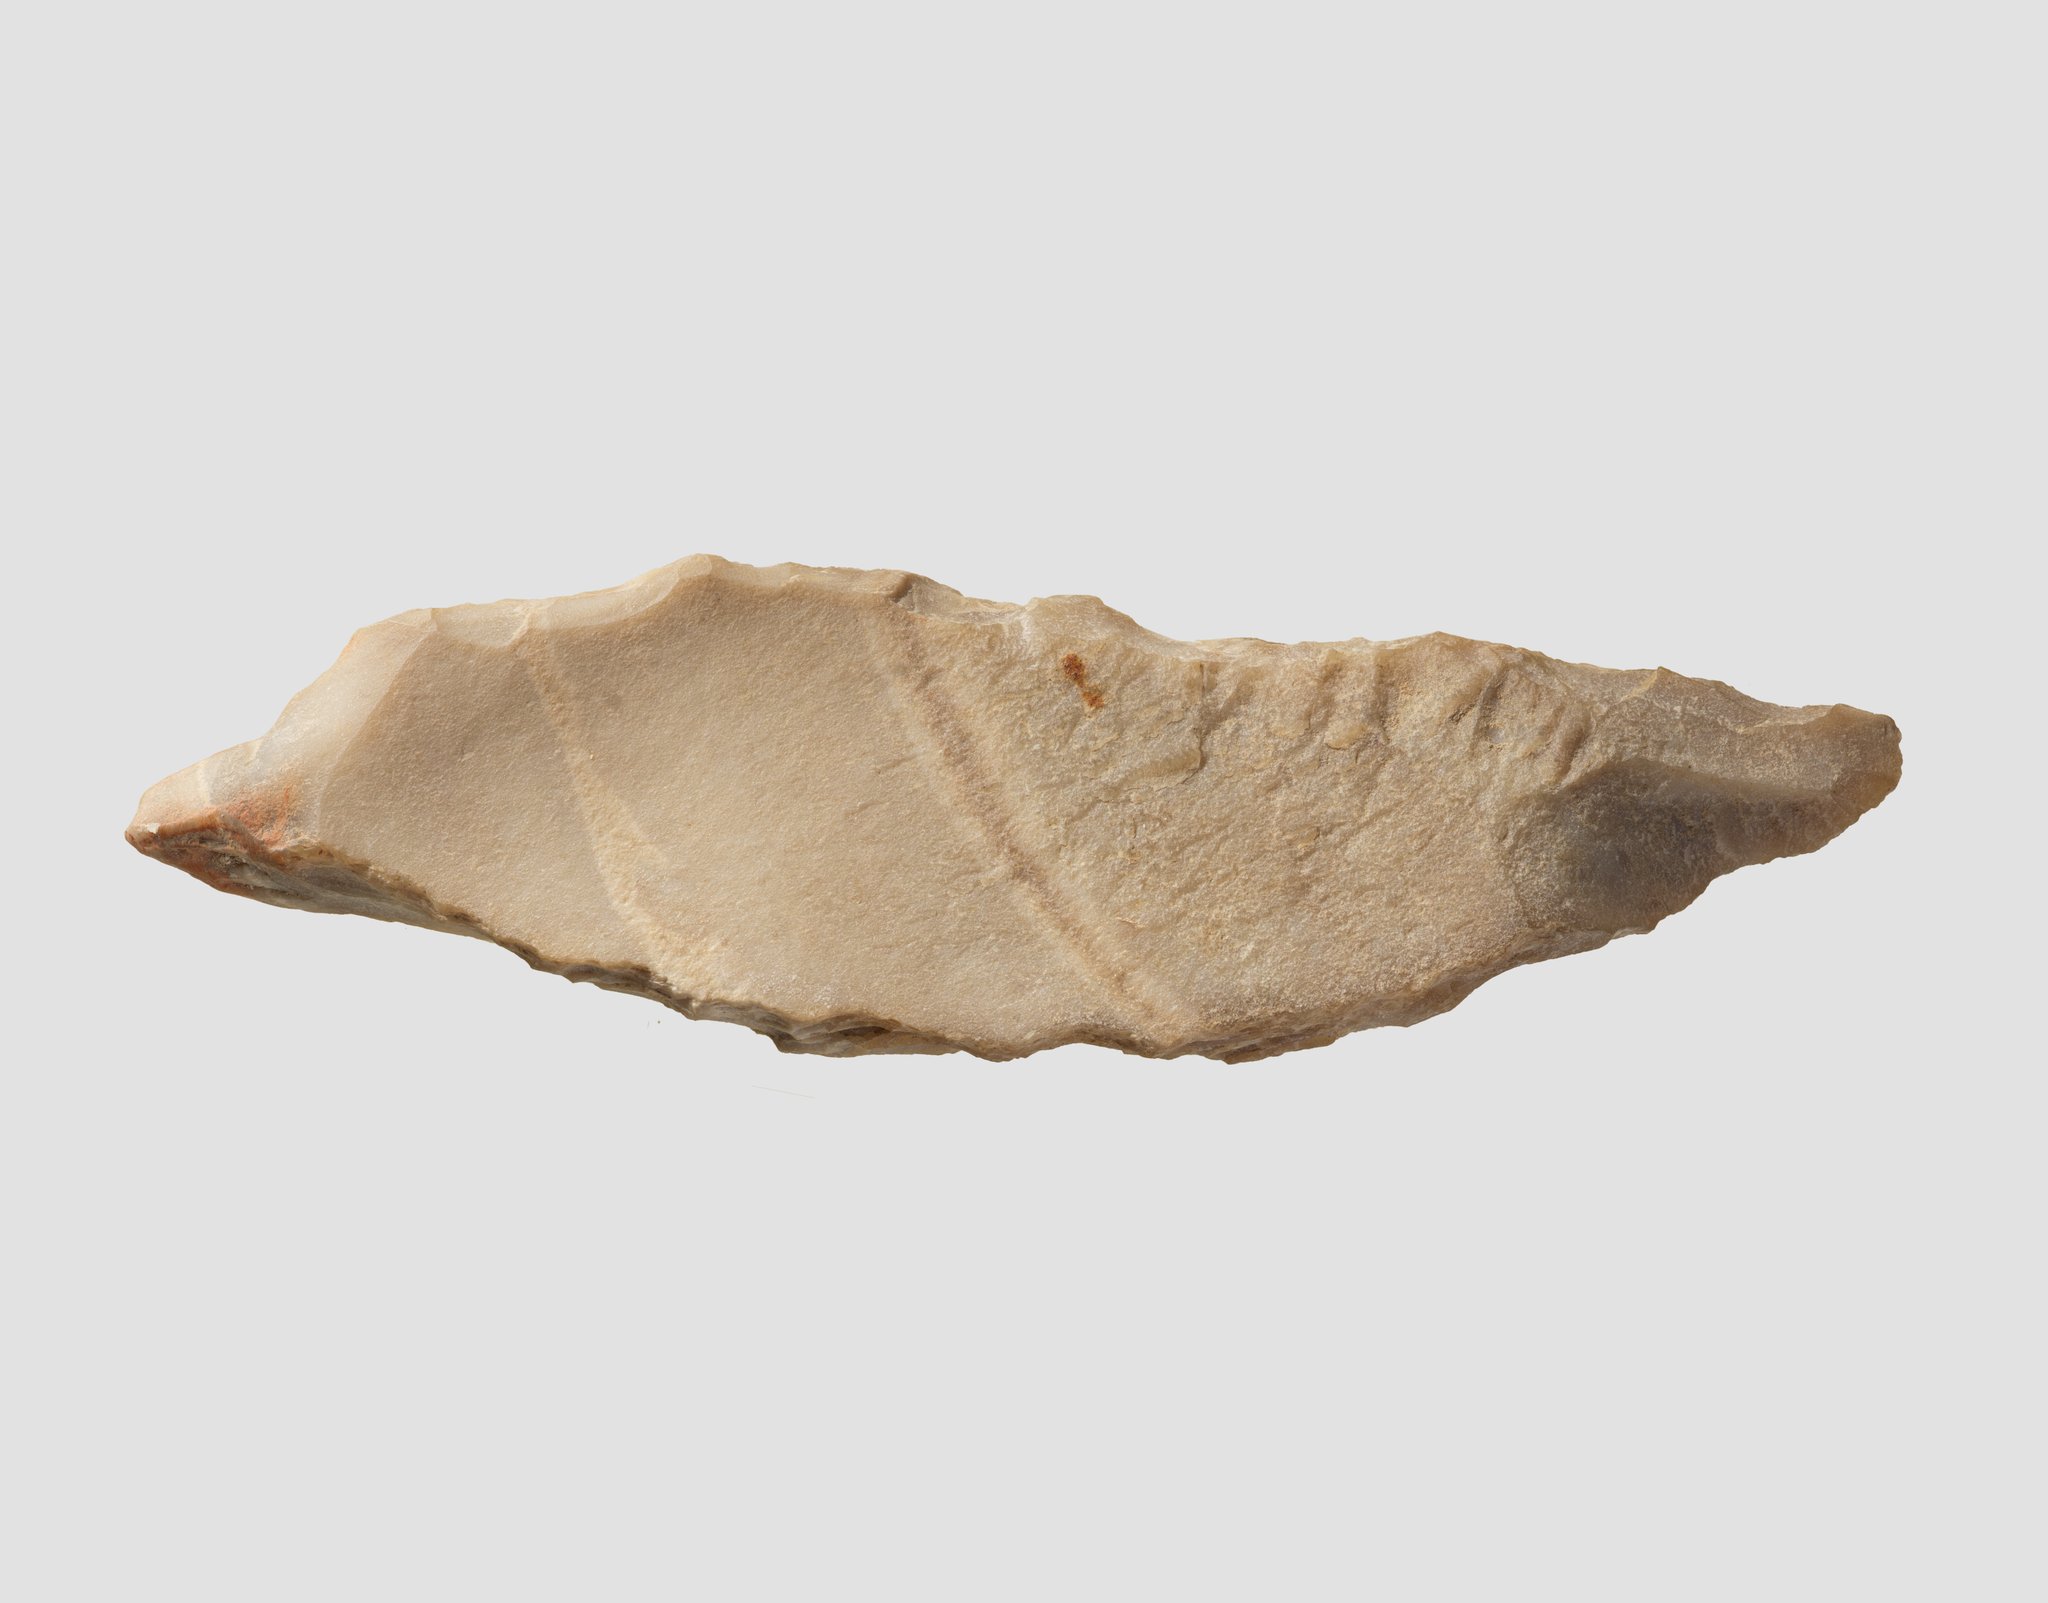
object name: awl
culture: ghassulian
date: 4600-3600 BCE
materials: stone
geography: levant